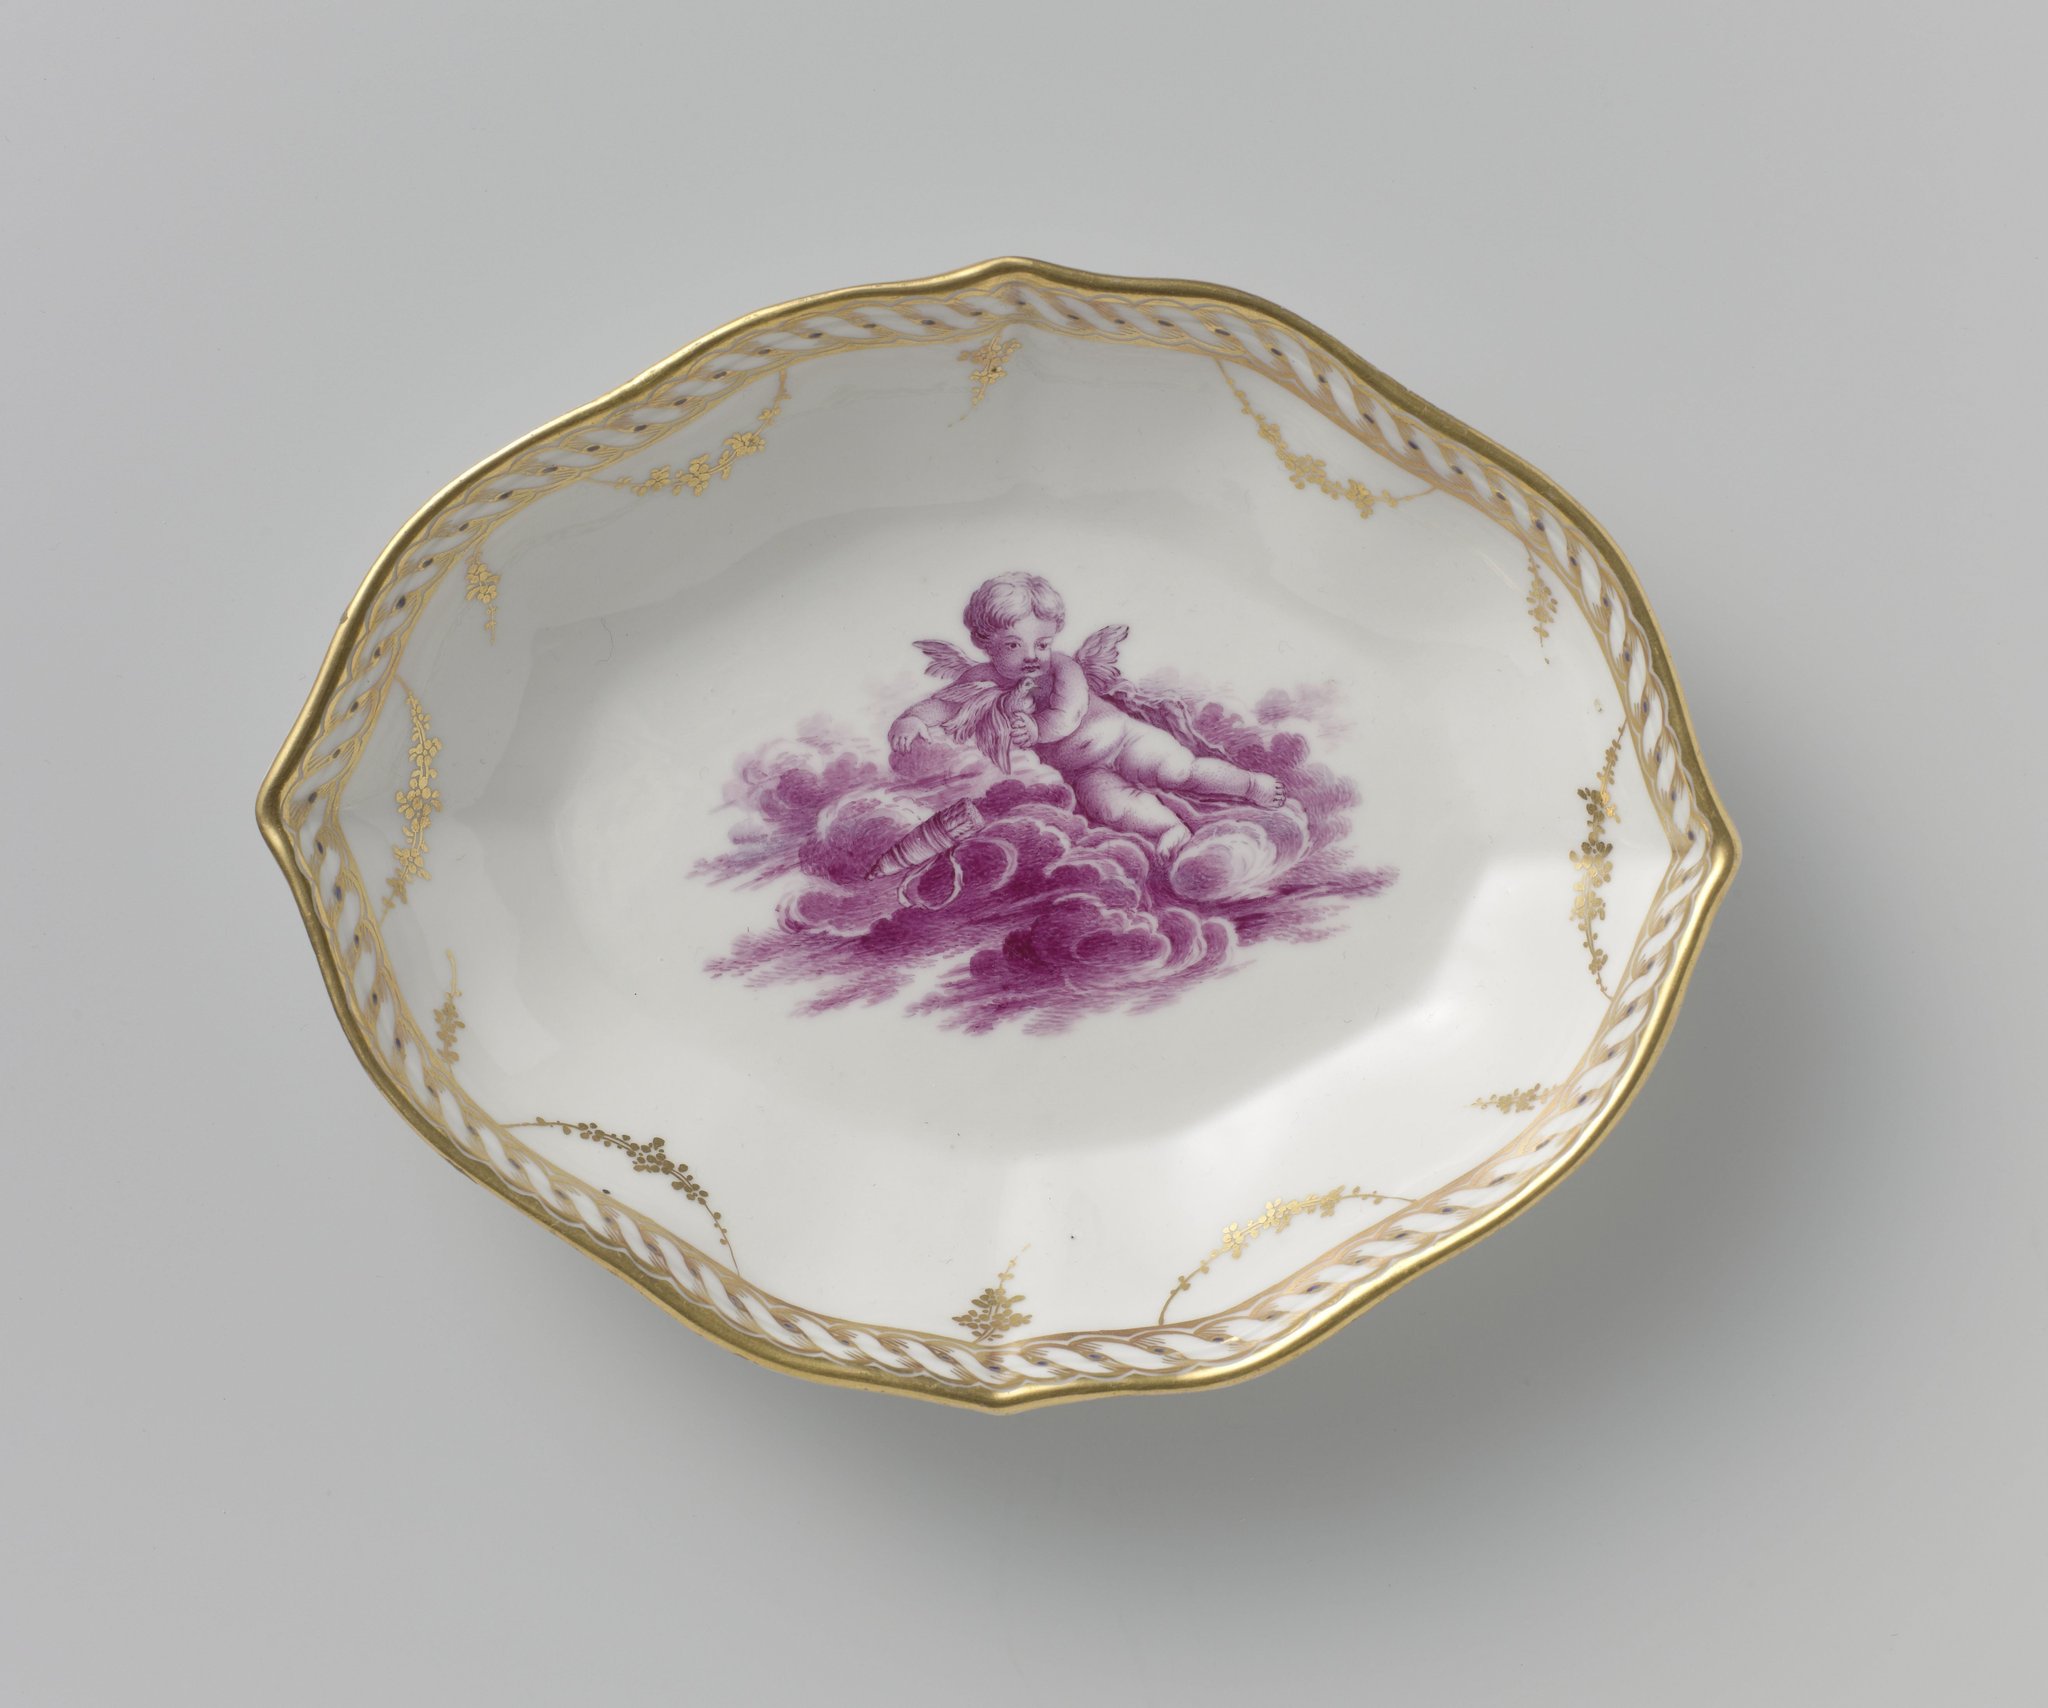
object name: service set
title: Stand with a putto on clouds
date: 1785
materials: glaze, gold, paint, porcelain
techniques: firing, forming, gilding, turning, vitrification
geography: germany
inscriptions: mark: ‘ooievaar’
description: Ovale pattipan van porselein met een geschulpte wand en rand, beschilderd op het glazuur in roze (camaïeu) en goud. Op het plat een putto op een wolk met een vogel en een pijlenkoker. De binnenrand met een gedraaide band, waaraan guirlandes en bloemtakken hangen. Gouden rand. Gemerkt op de onderzijde met de ooievaar.